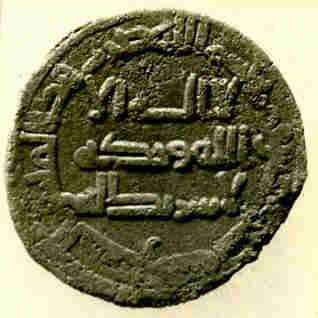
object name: coin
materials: copper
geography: al-kaffan